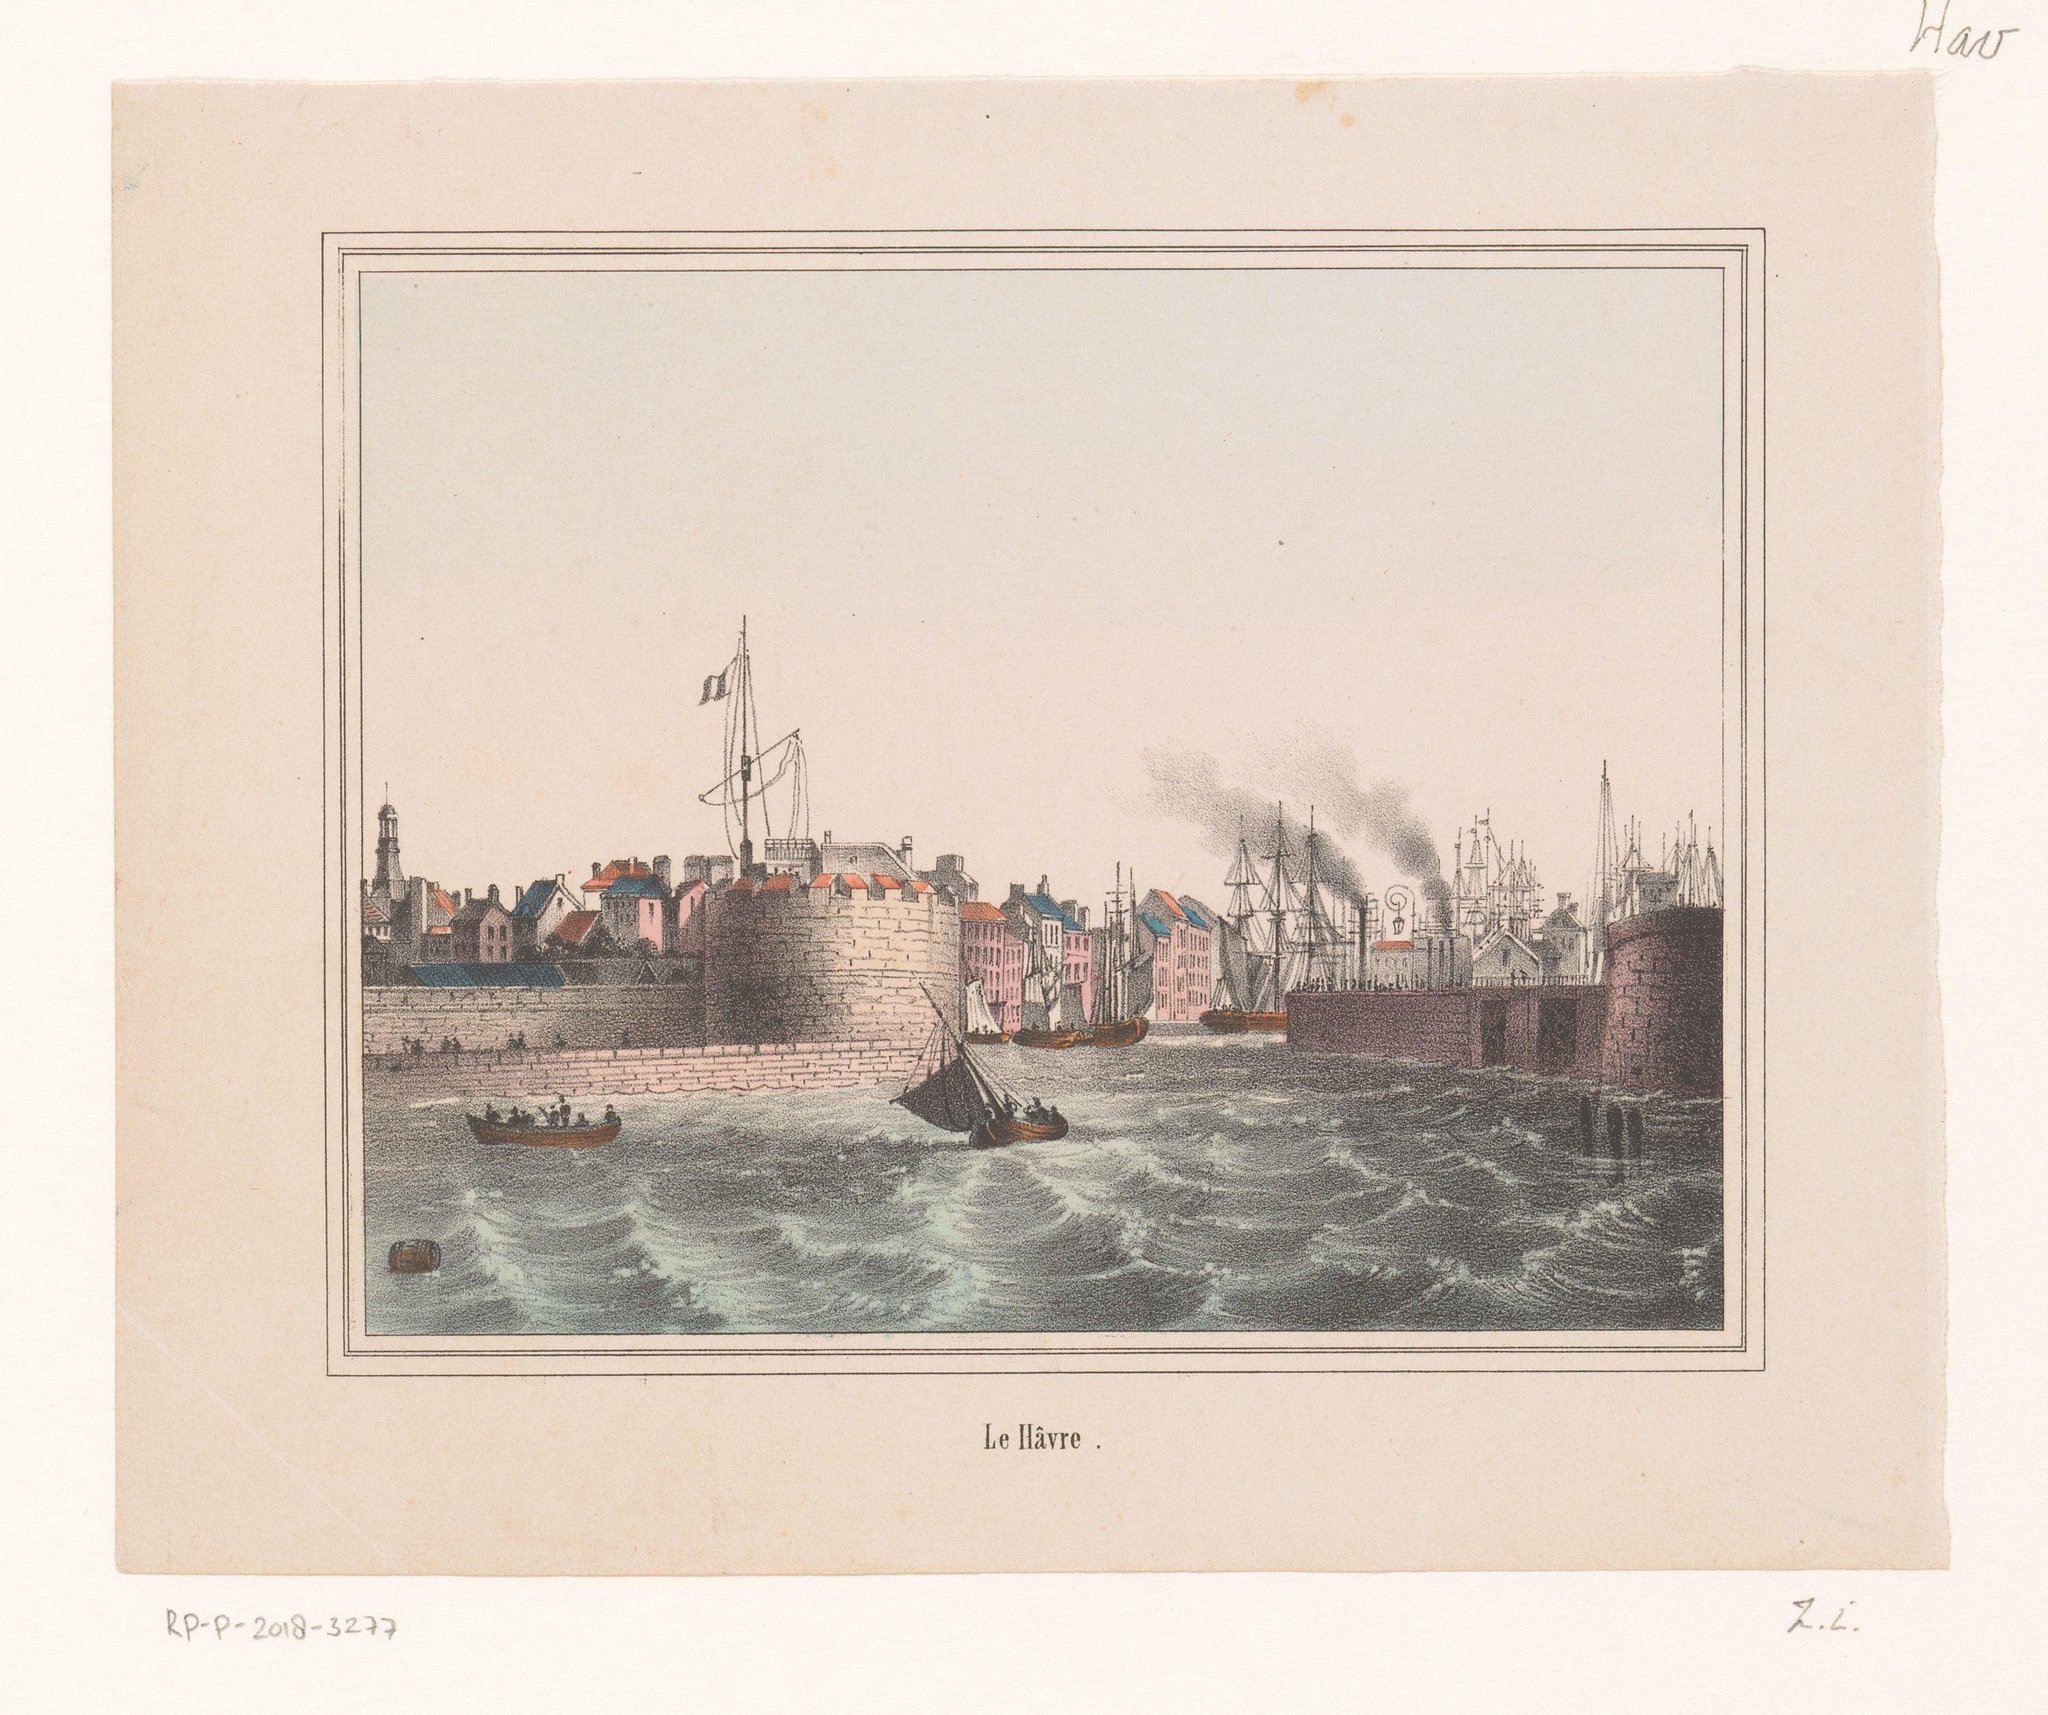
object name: print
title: Haven van Le Hâvre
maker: Anonymous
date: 1820-1860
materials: paper, watercolor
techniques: brush, hand coloring, lithograph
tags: harbour, le havre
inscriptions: collector's mark: Lugt 2228